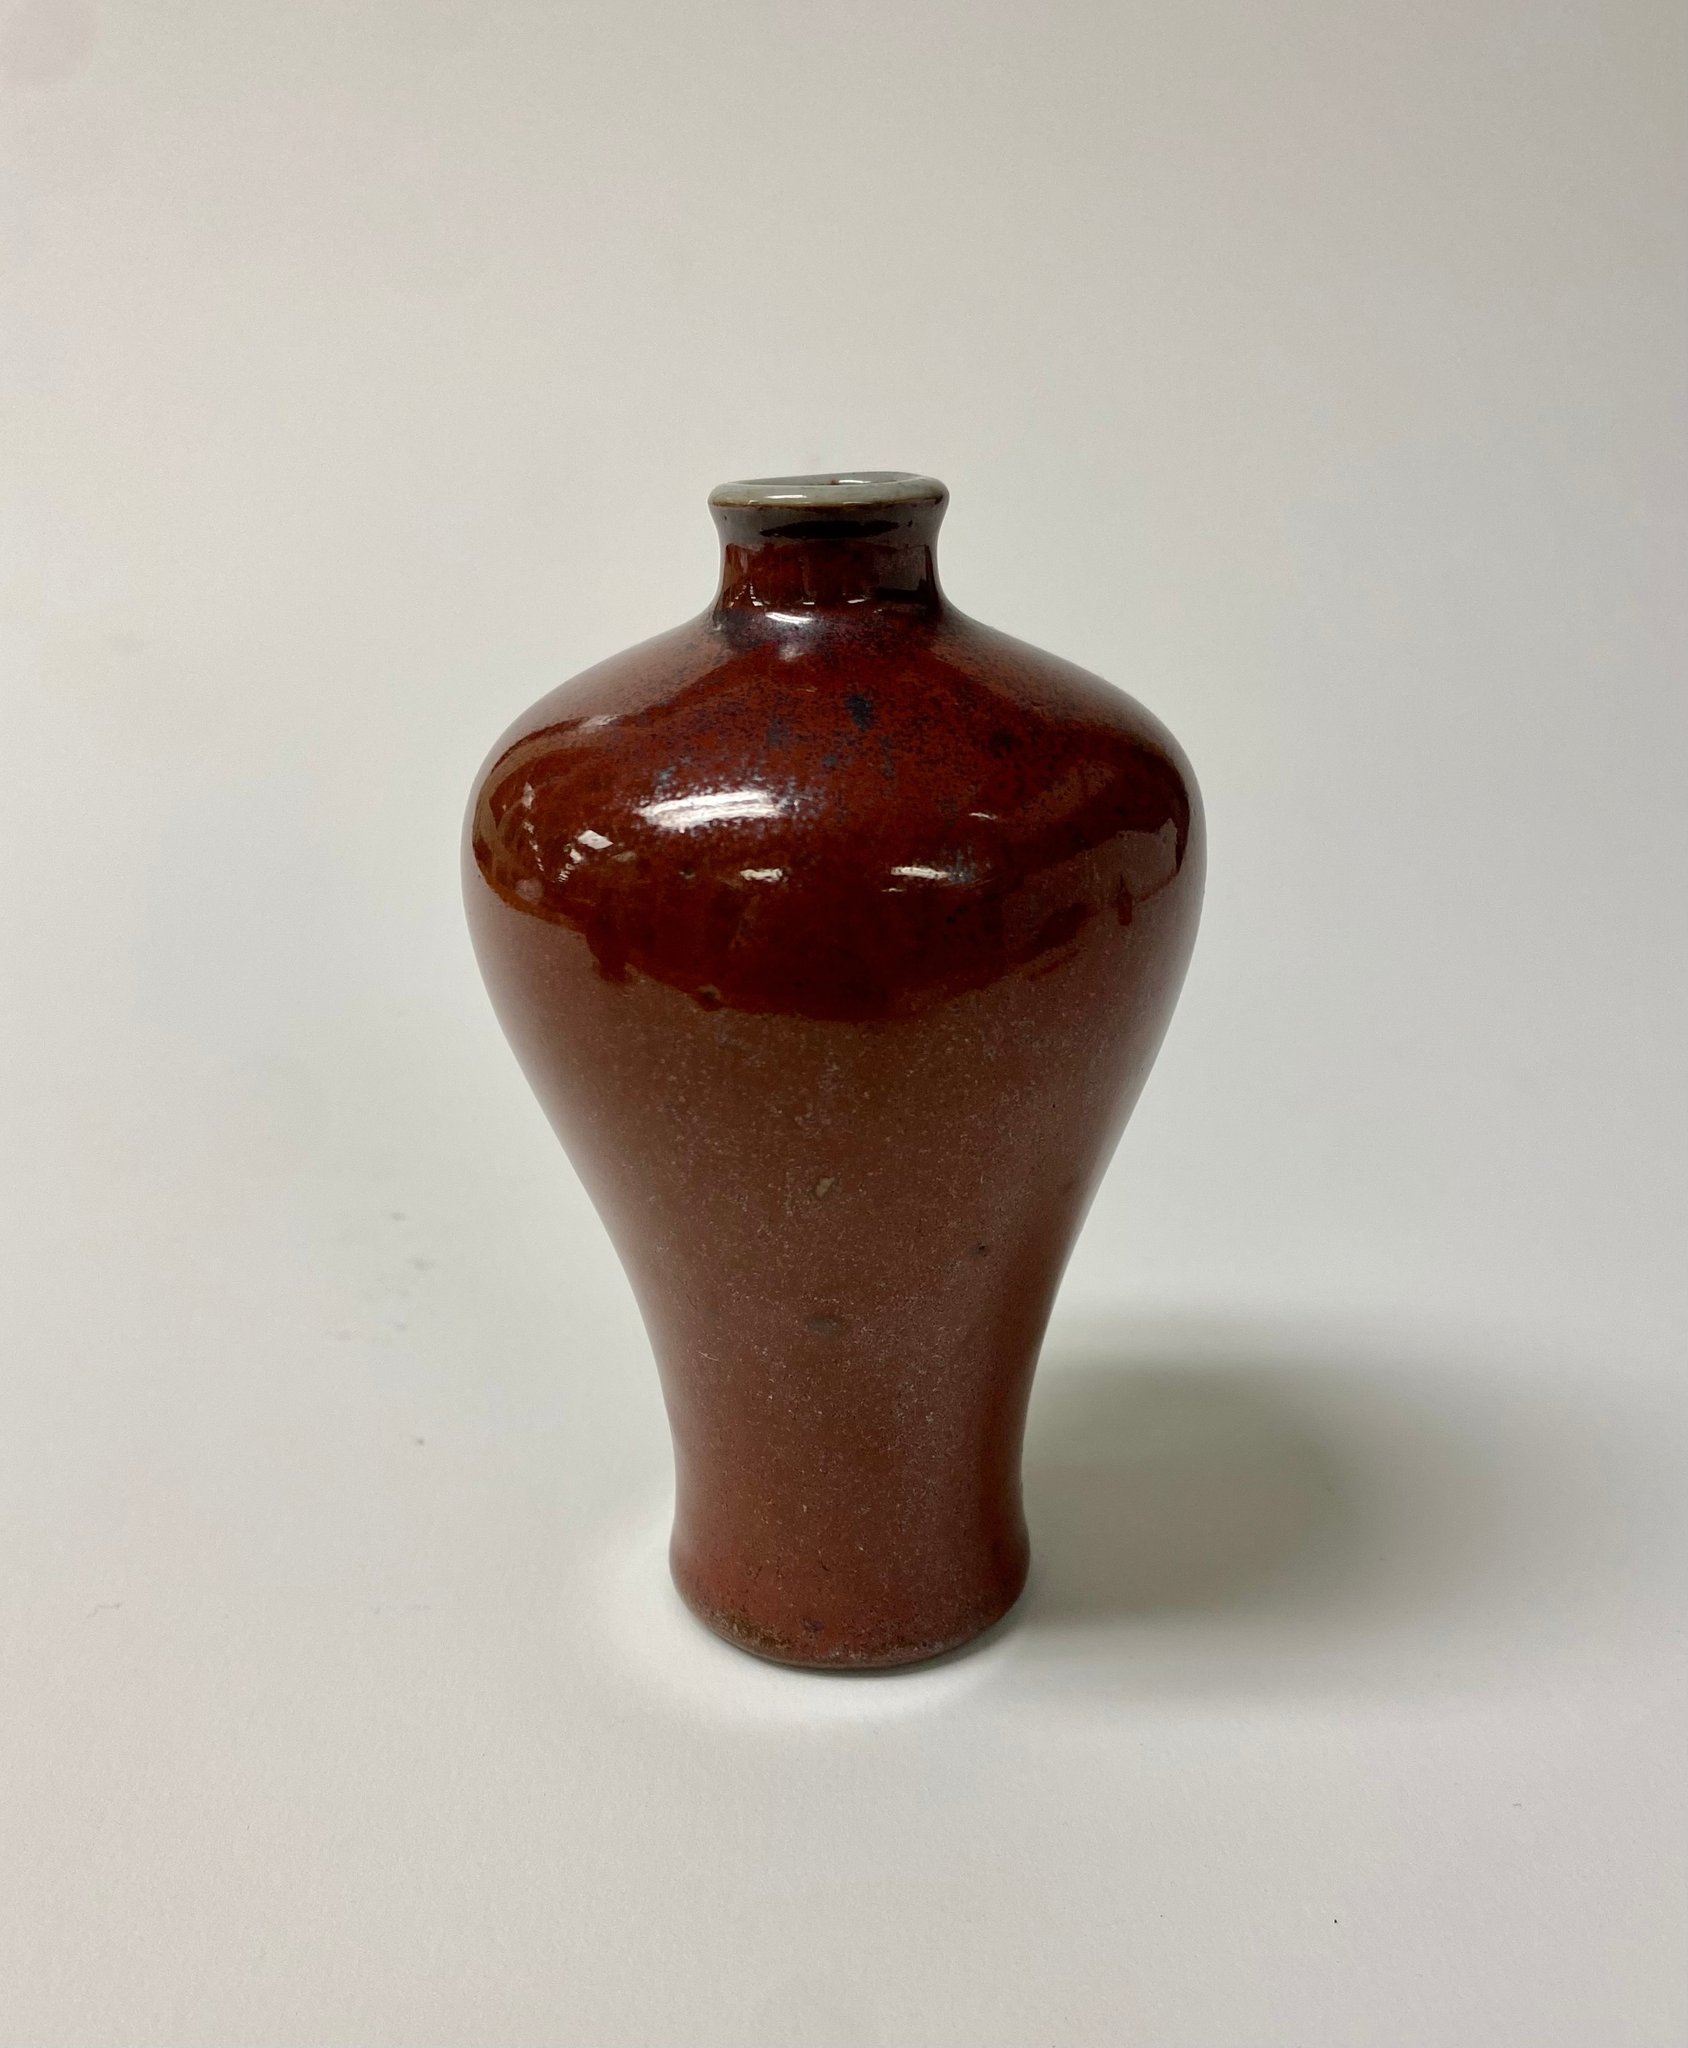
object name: vase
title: Miniature meiping vase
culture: chinese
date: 1701-1800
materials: glaze, iron, porcelain